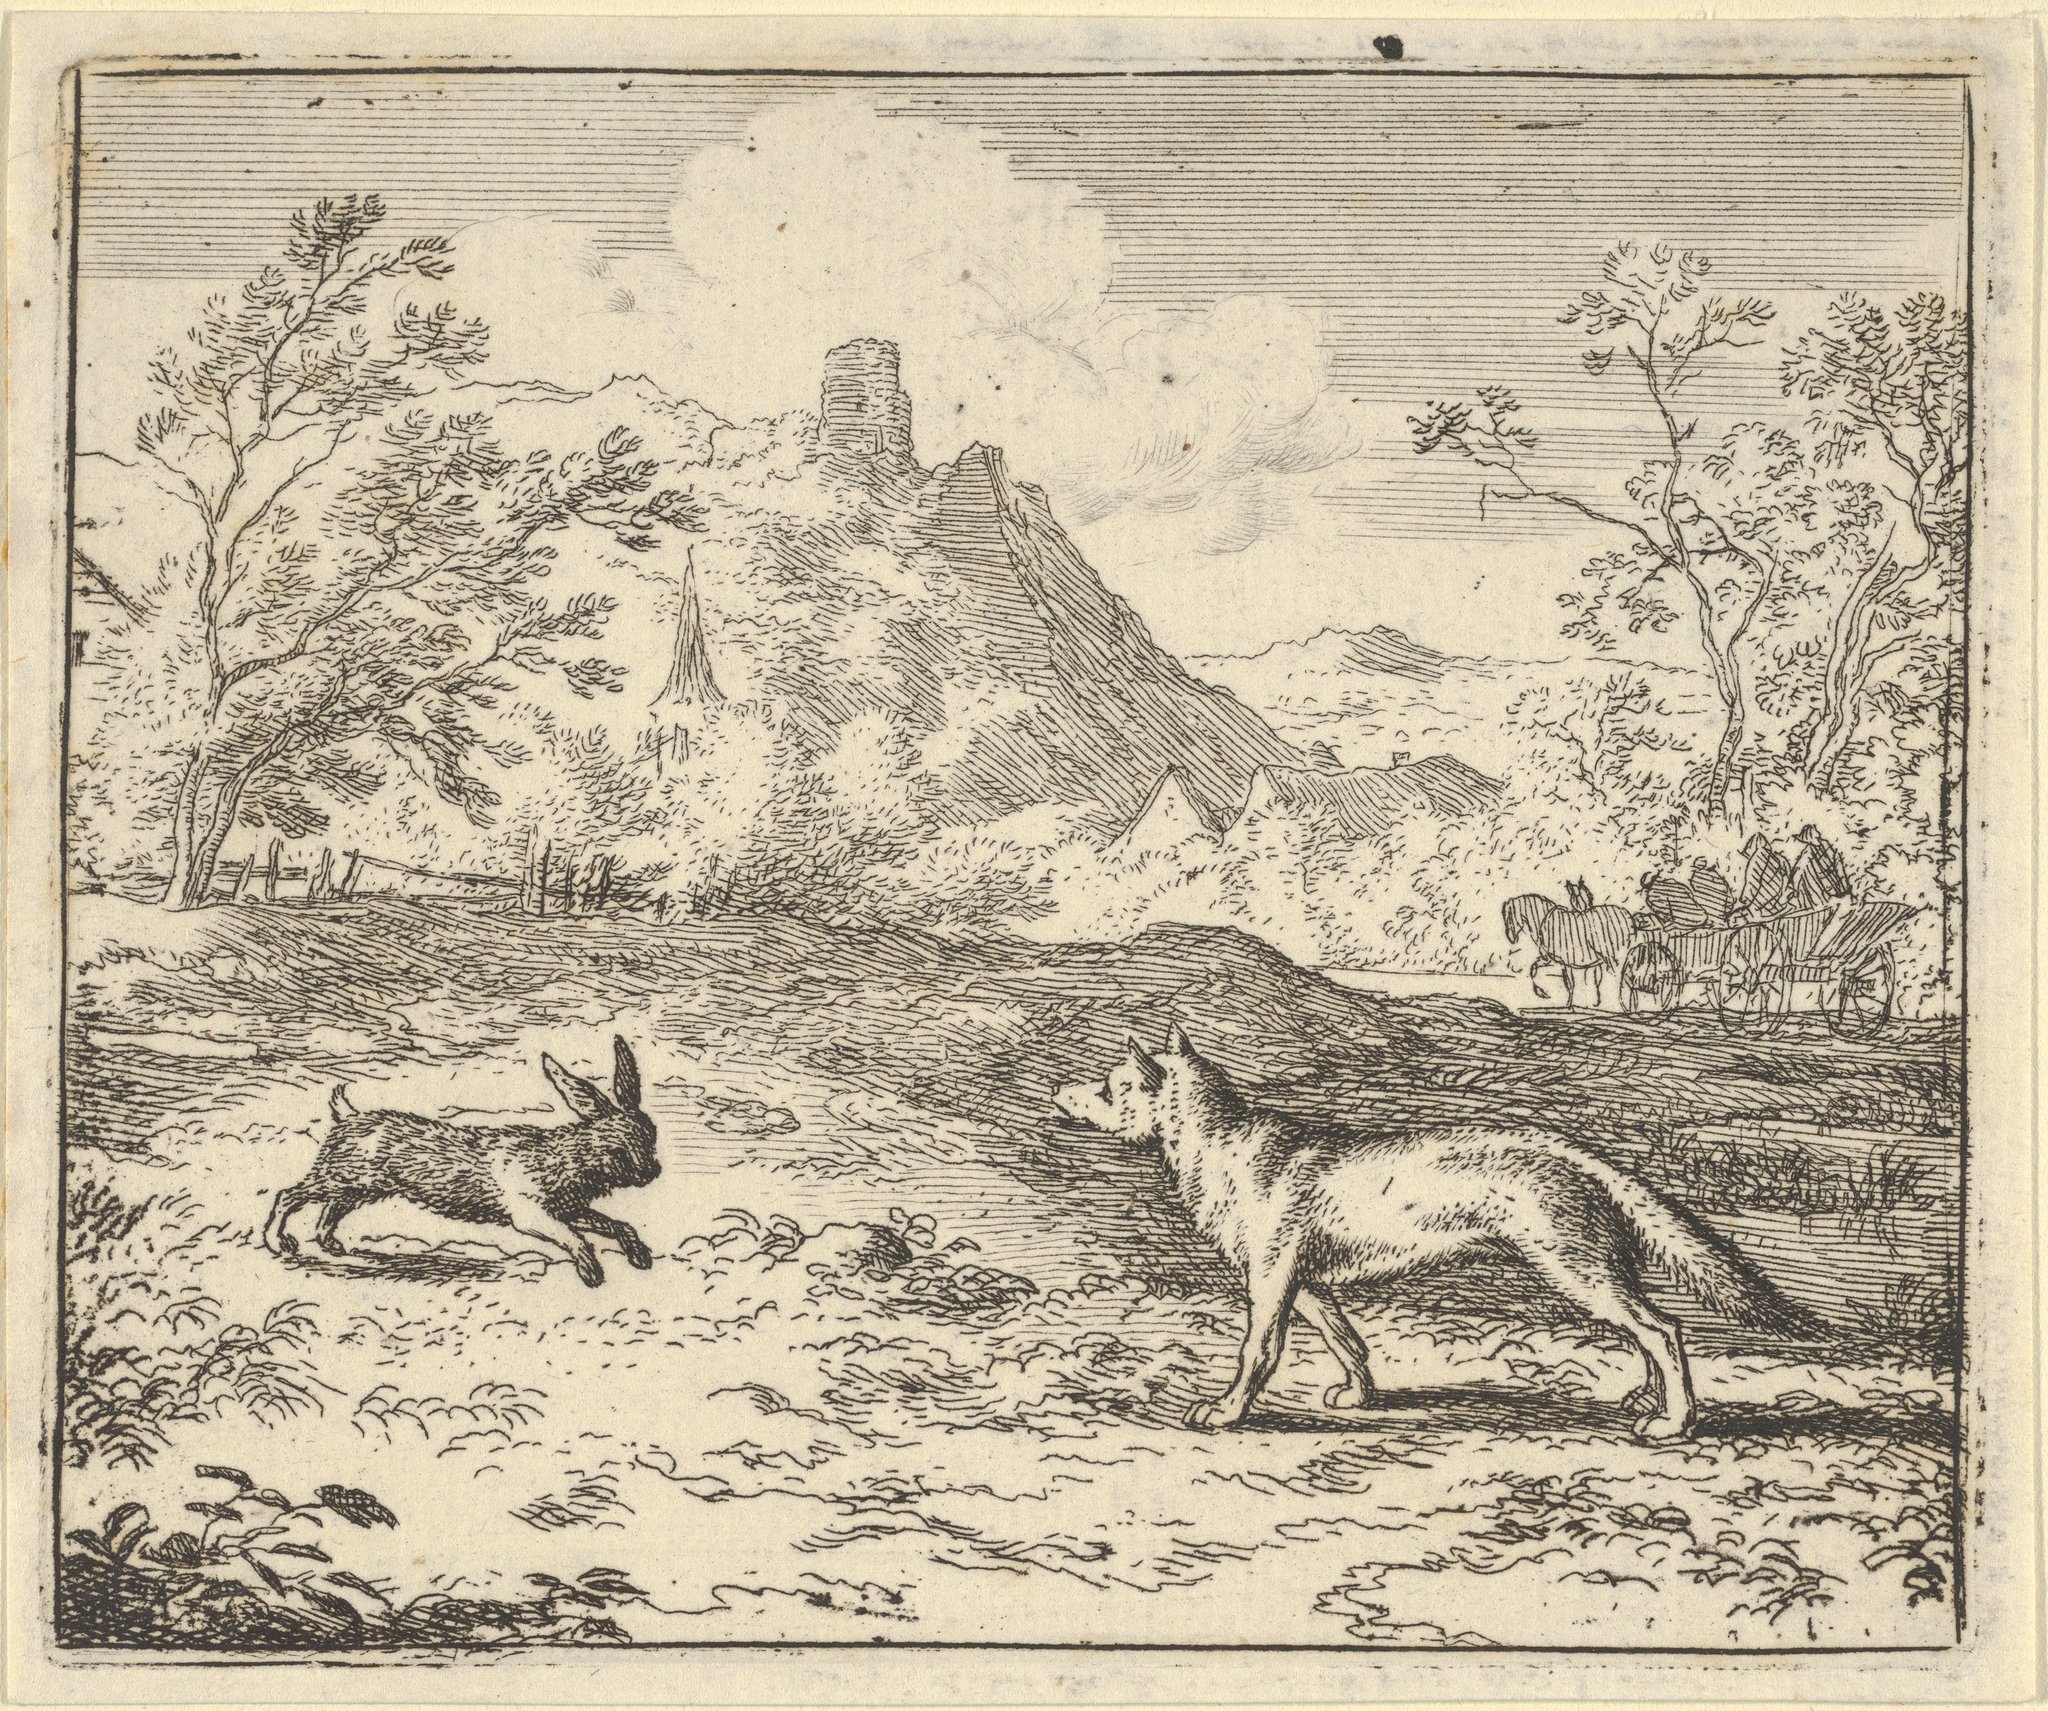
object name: print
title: Renard Lies that the Rabbit Insulted One of His Children from Hendrick van Alcmar's Renard The Fox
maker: allart van everdingen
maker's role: artist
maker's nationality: dutch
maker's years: 1621-1675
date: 1650-1675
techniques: engraving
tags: foxes,rabbits